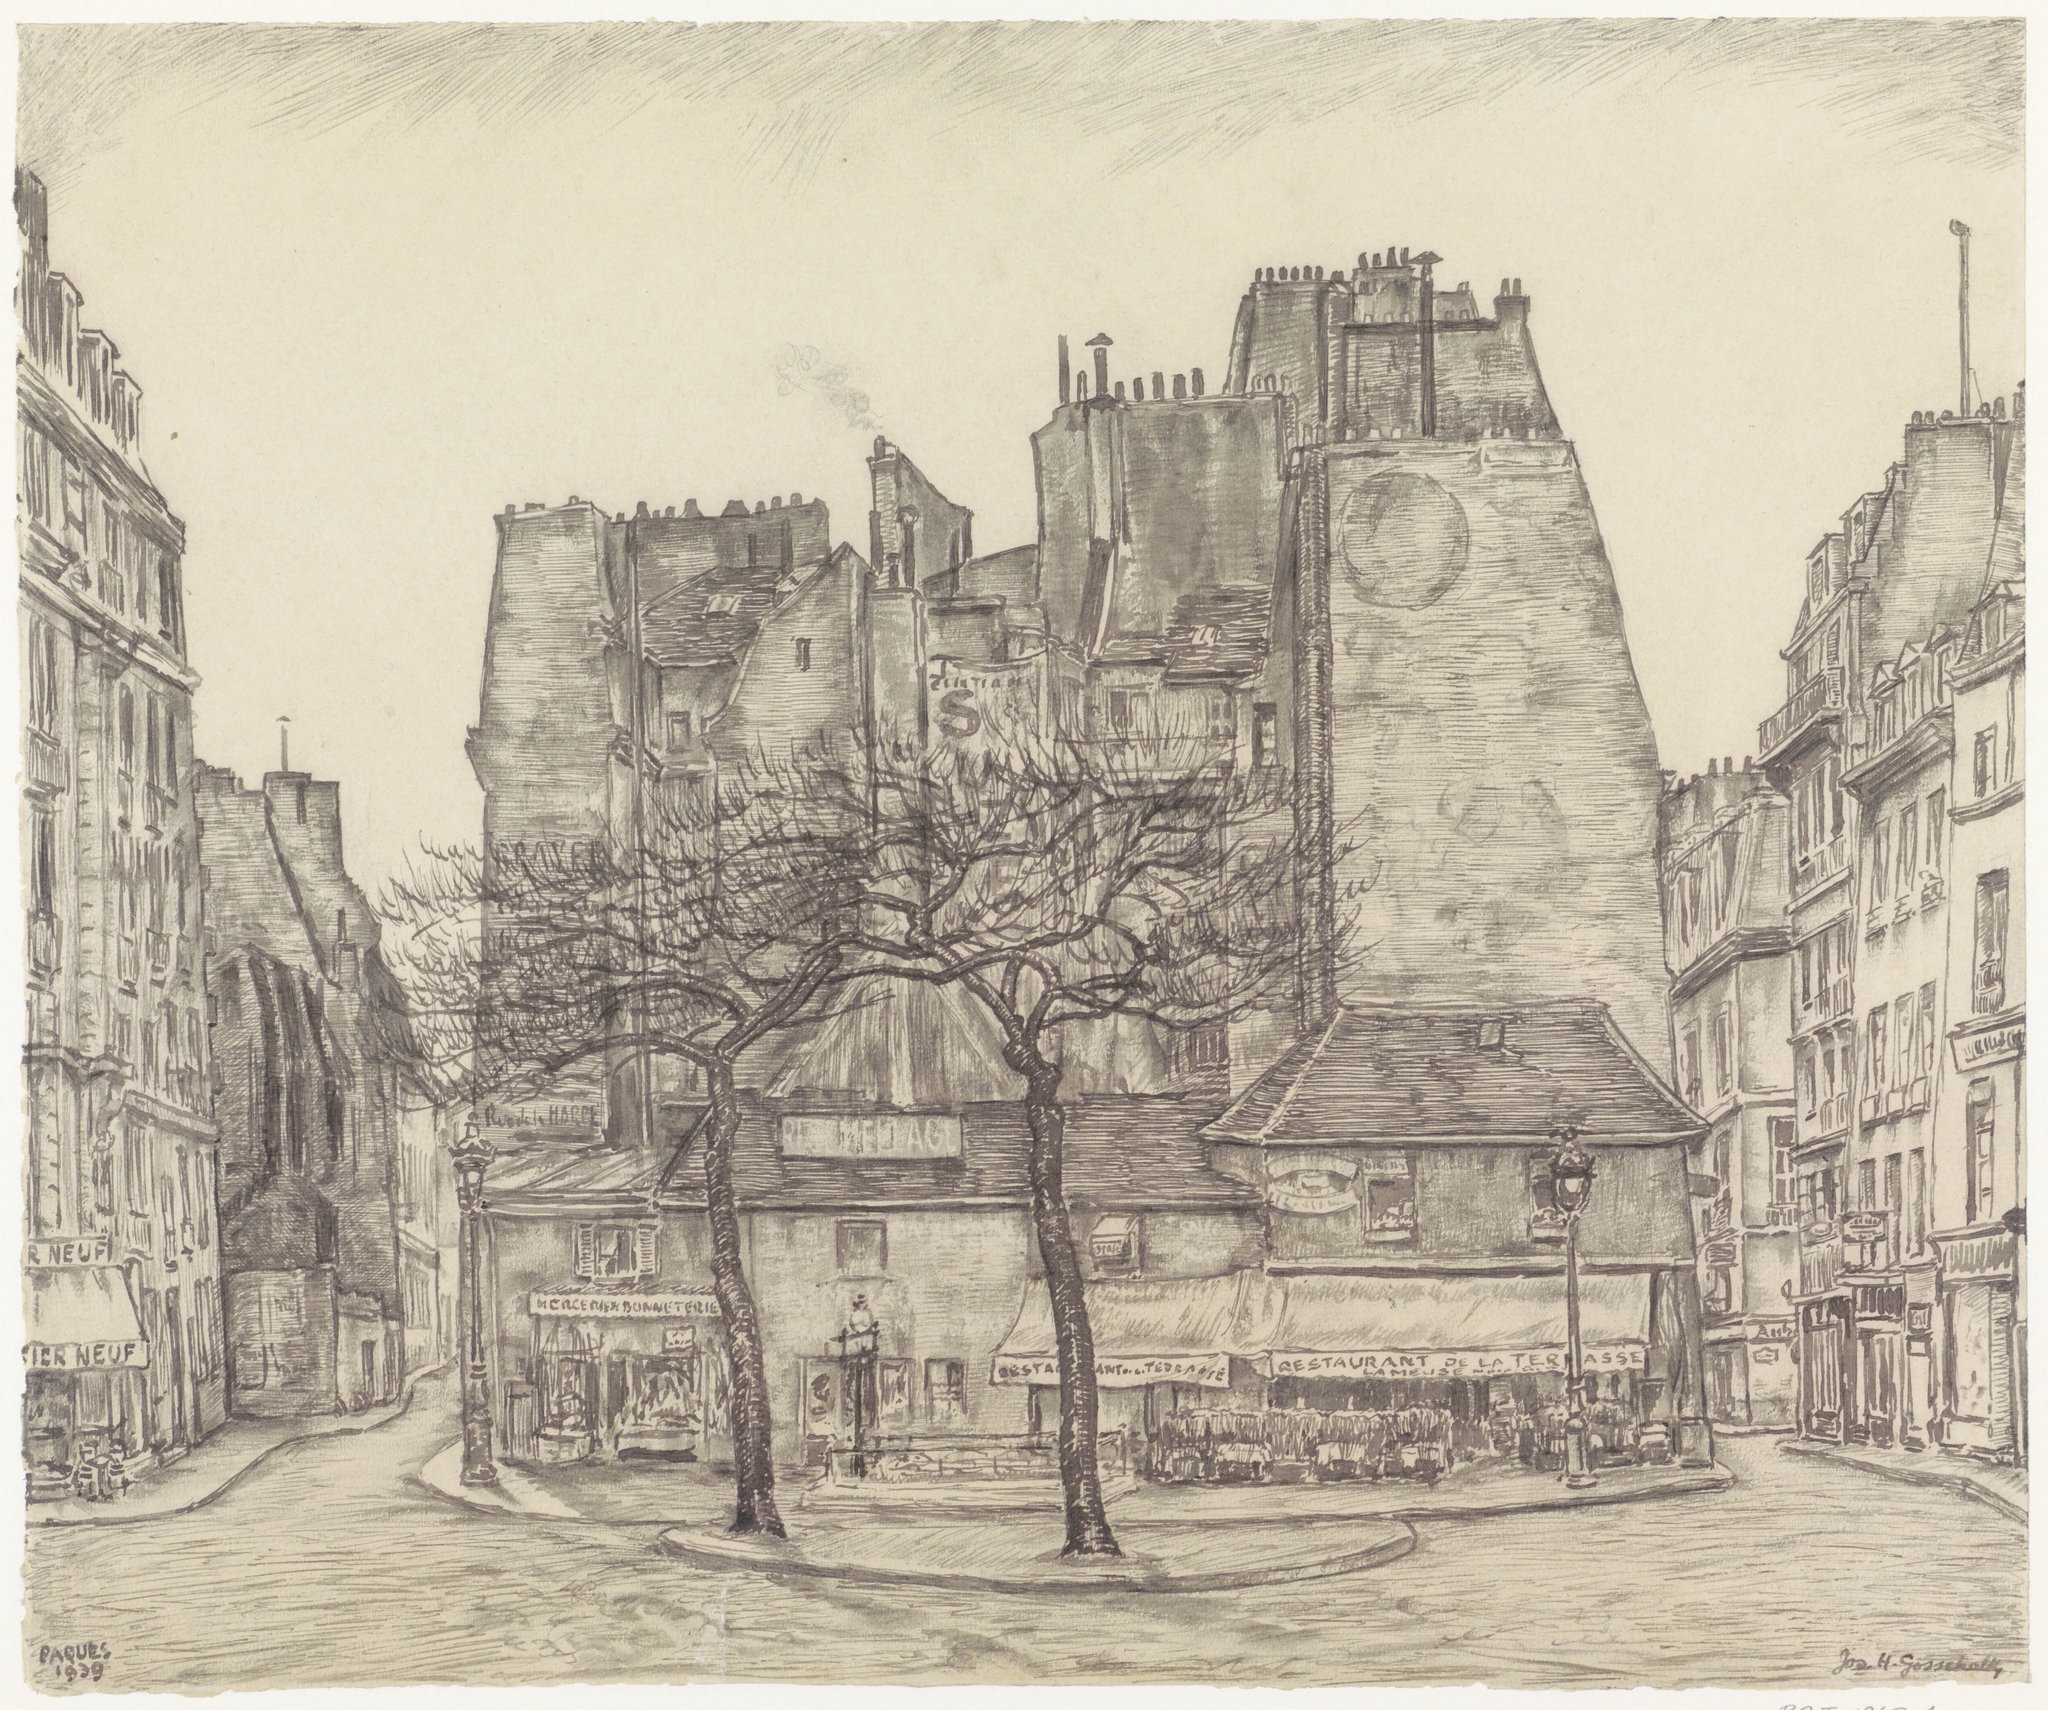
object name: drawing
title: Parijs stadsgezicht: Place St. André des Arts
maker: joseph henry gosschalk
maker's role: draughtsman, print maker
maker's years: 1875-1952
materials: chalk, paper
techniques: brush, pen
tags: square, place, circus, etc.